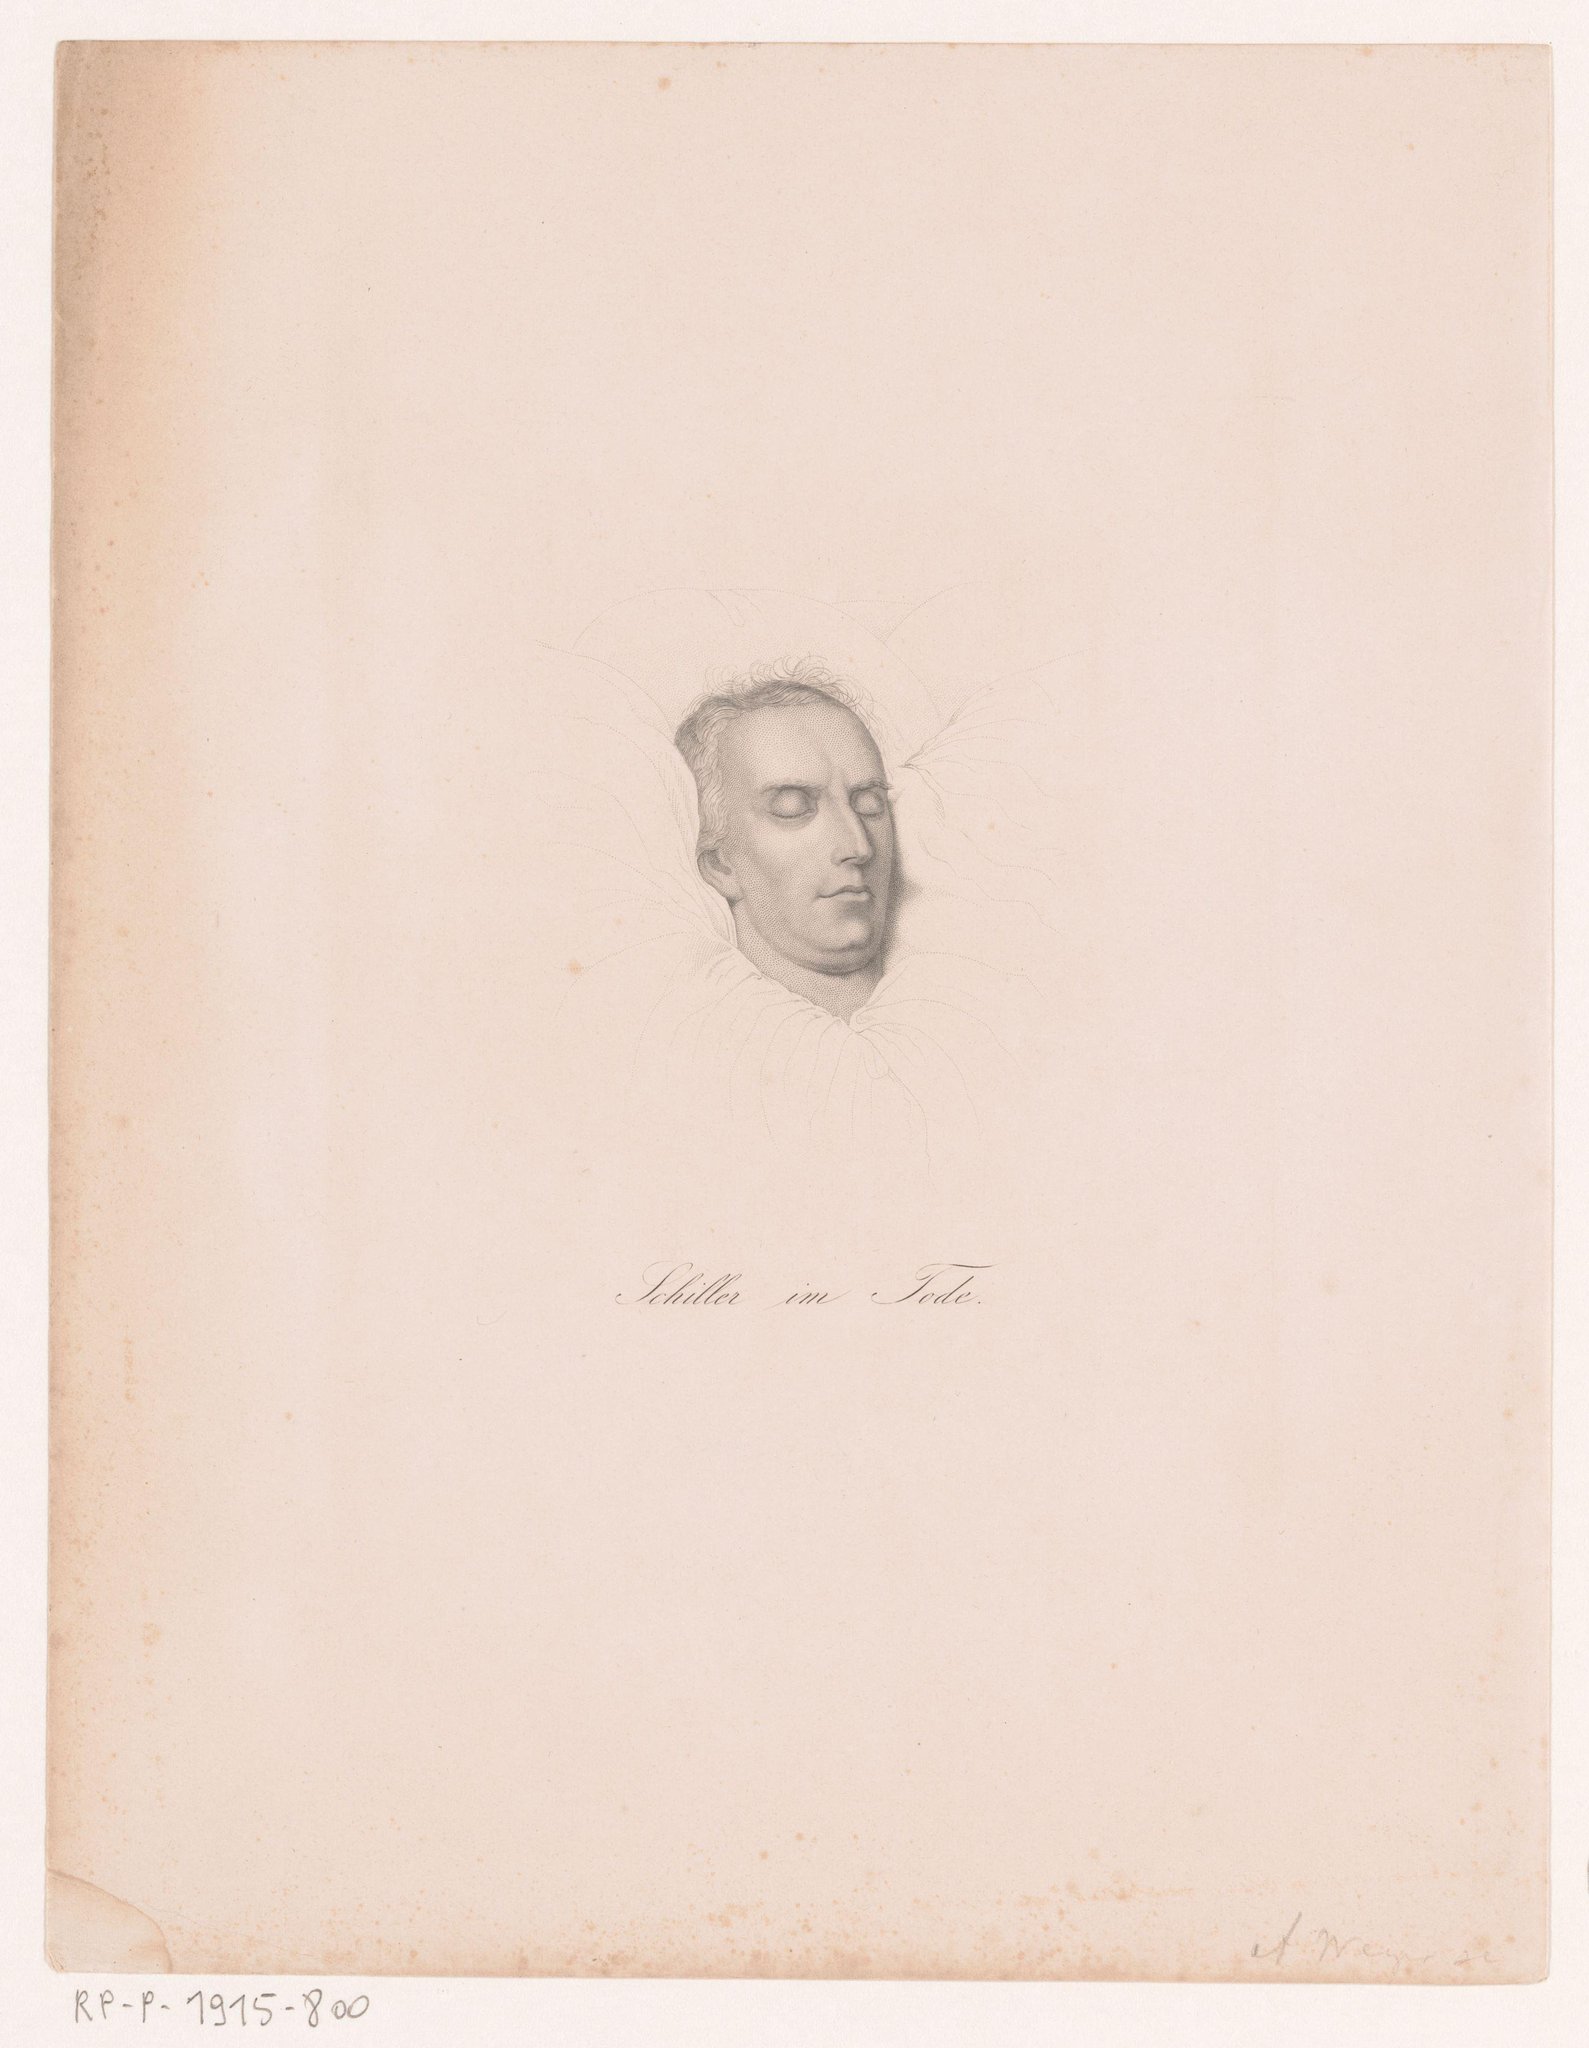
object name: print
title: Friedrich von Schiller op zijn sterfbed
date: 1840-1892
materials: paper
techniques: engraving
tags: friedrich von schiller, deathbed, historical persons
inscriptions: collector's mark: Lugt 2228